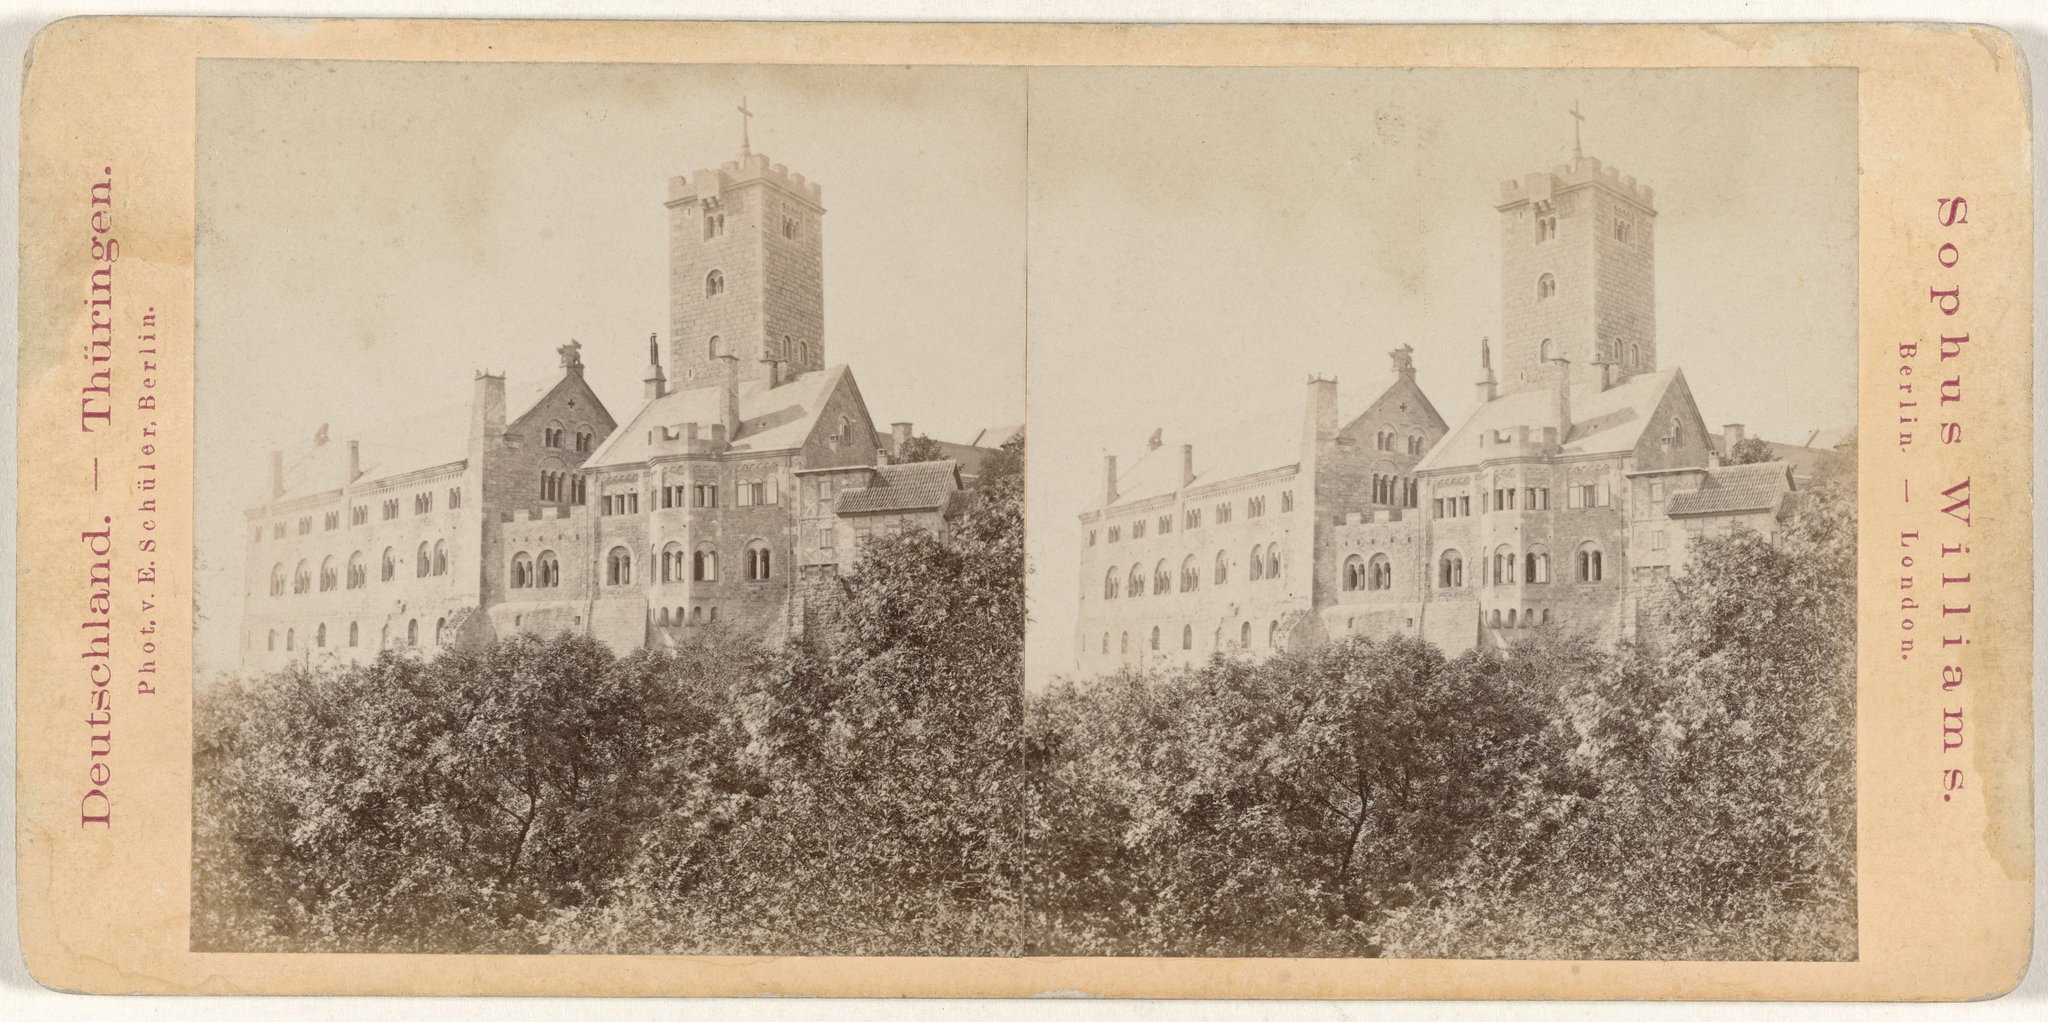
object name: stereograph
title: Die Wartburg. Ostseite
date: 1873-1890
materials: cardboard, paper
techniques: albumen print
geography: berlin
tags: castle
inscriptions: number: ‘436.’